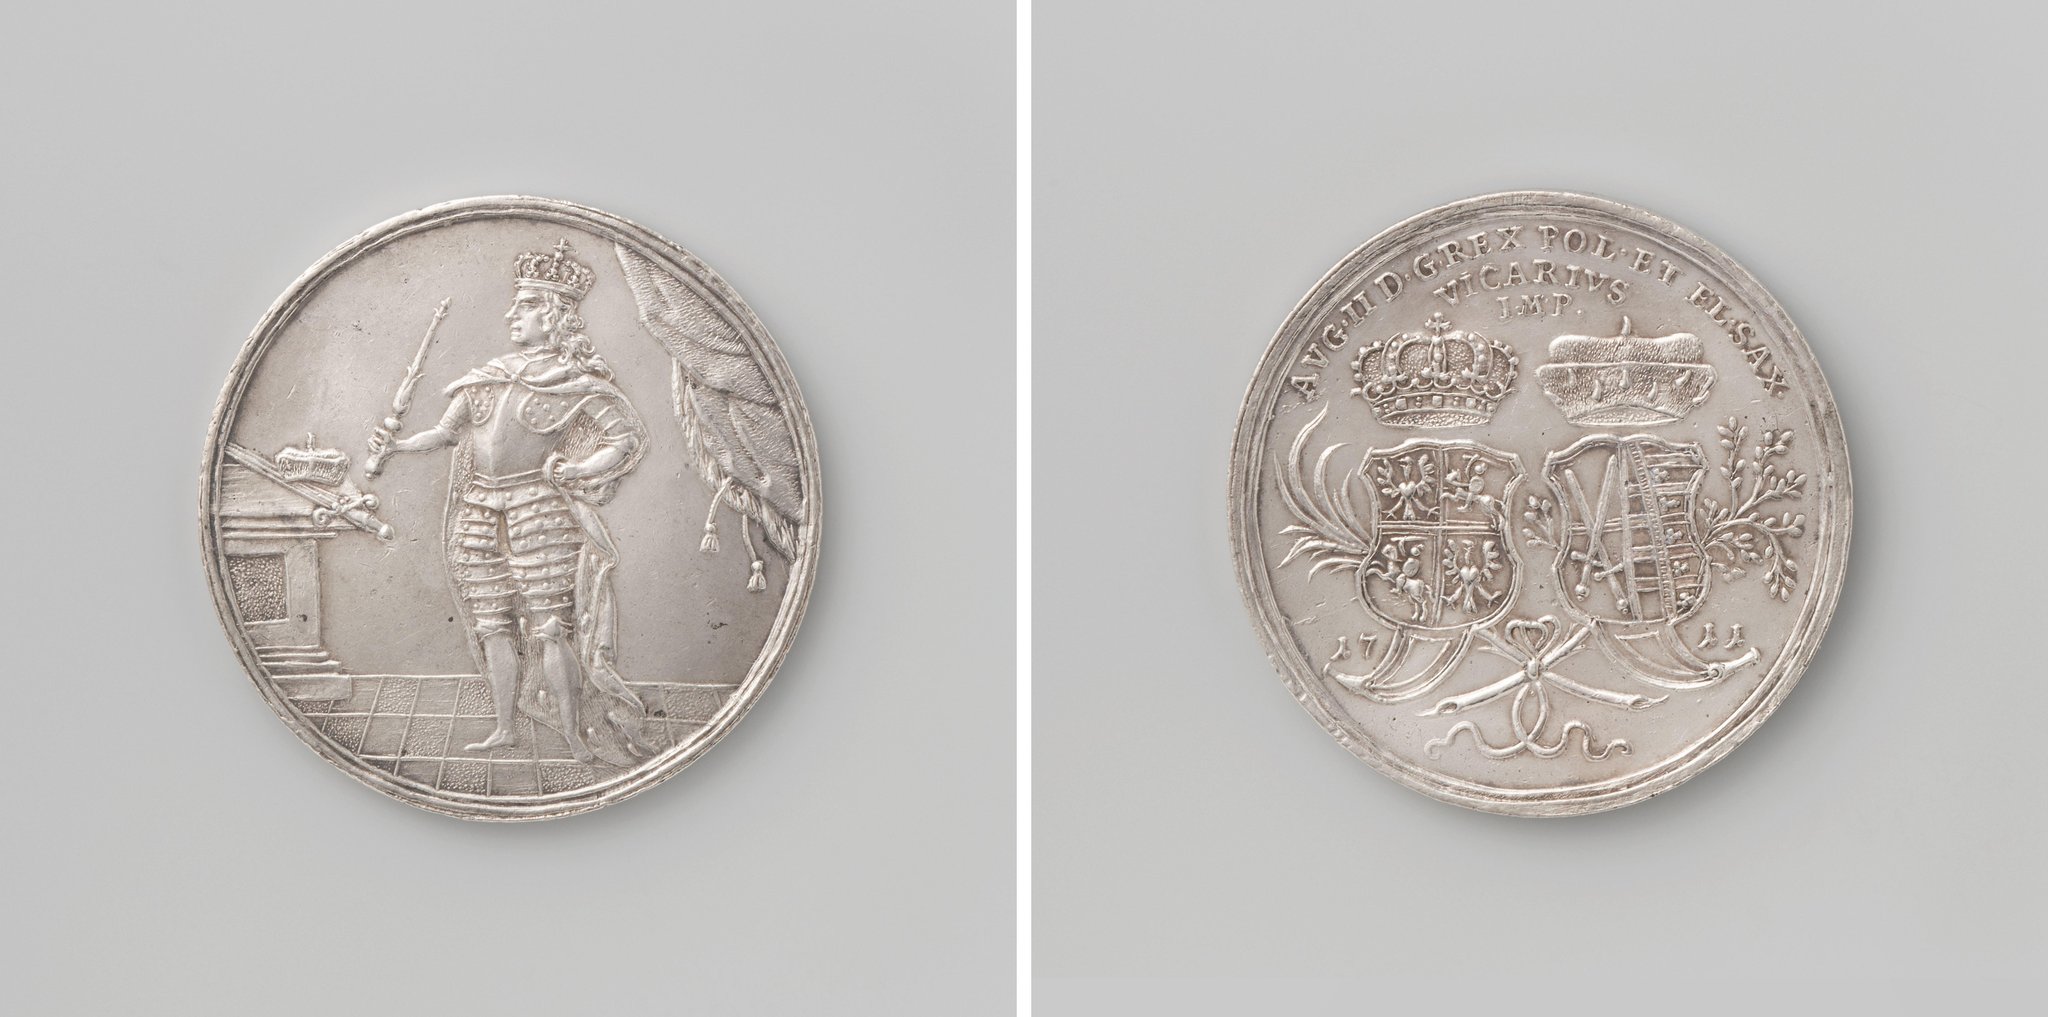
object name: history medal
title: Frederik Augustus, koning van Polen en keurvorst van Saksen aangesteld tot stadhouder van het Roomse Rijk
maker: Anonymous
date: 1711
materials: silver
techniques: striking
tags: august ii (king of poland)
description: Zilveren penning. Voorzijde: man in wapenrusting met kroon en scepter staande naast tafel, waarop keurvorstelijke muts en degen liggen. Keerzijde: twee wapenschilden, waarvan linker onder kroon en rechter onder keurvorstelijke muts voor samengebonden palm- en olijftak onder drieregelig opschrift.